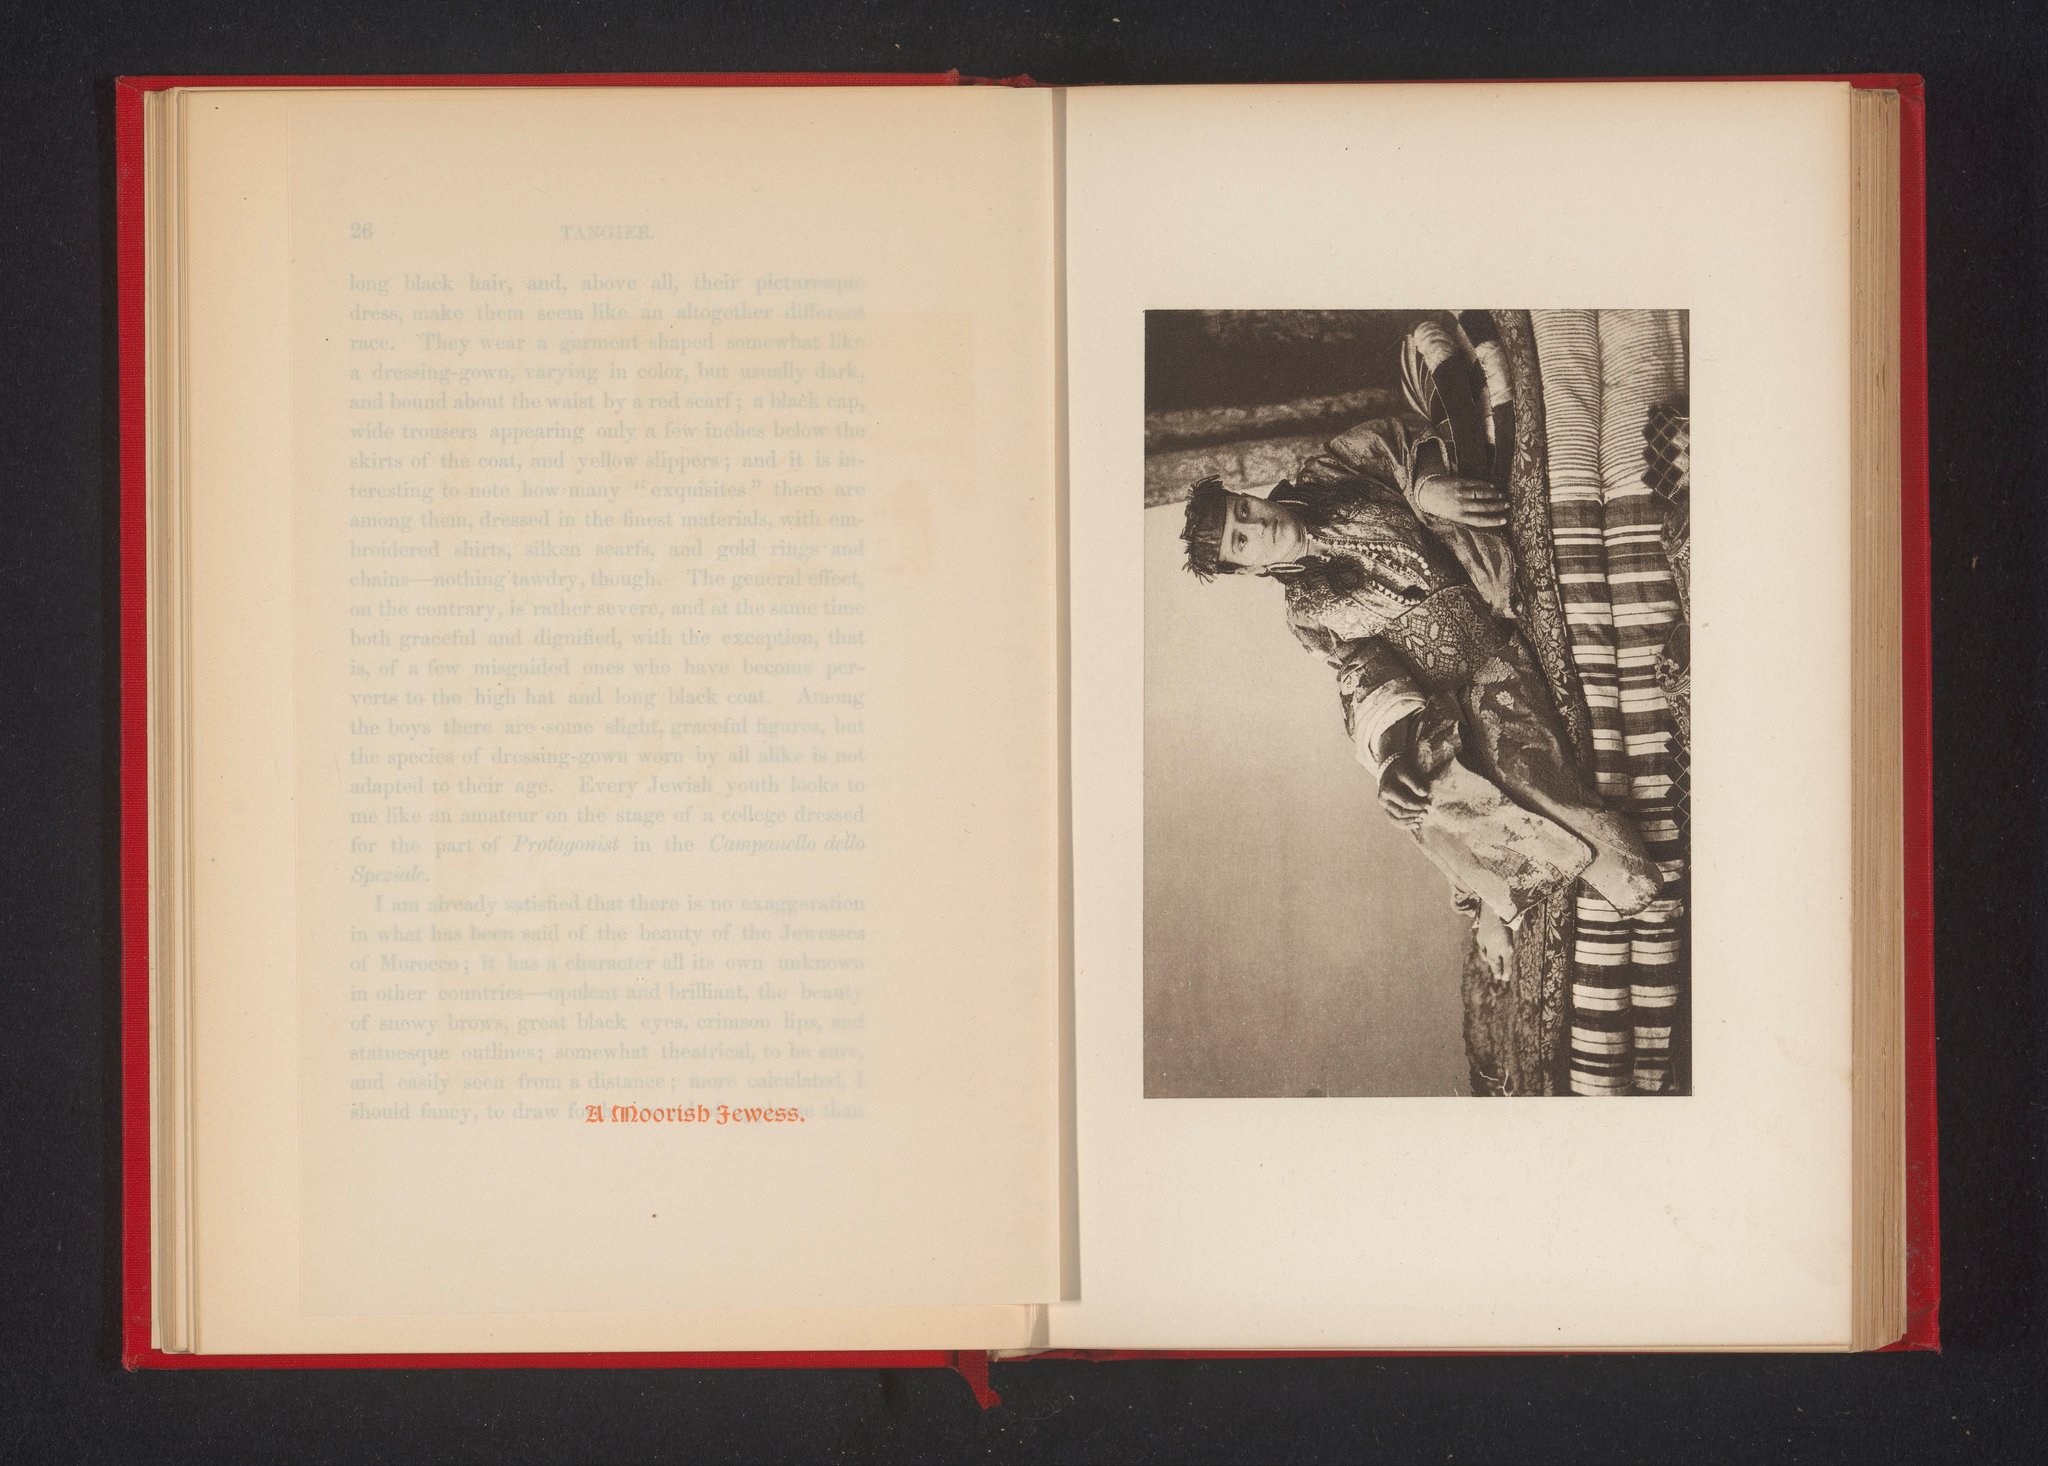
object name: page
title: Portret van een onbekende vrouw op een divan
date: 1887-1897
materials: paper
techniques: photoaquatint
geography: morocco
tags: seating furniture, adult woman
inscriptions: title: ‘A Moorish Jewess.’